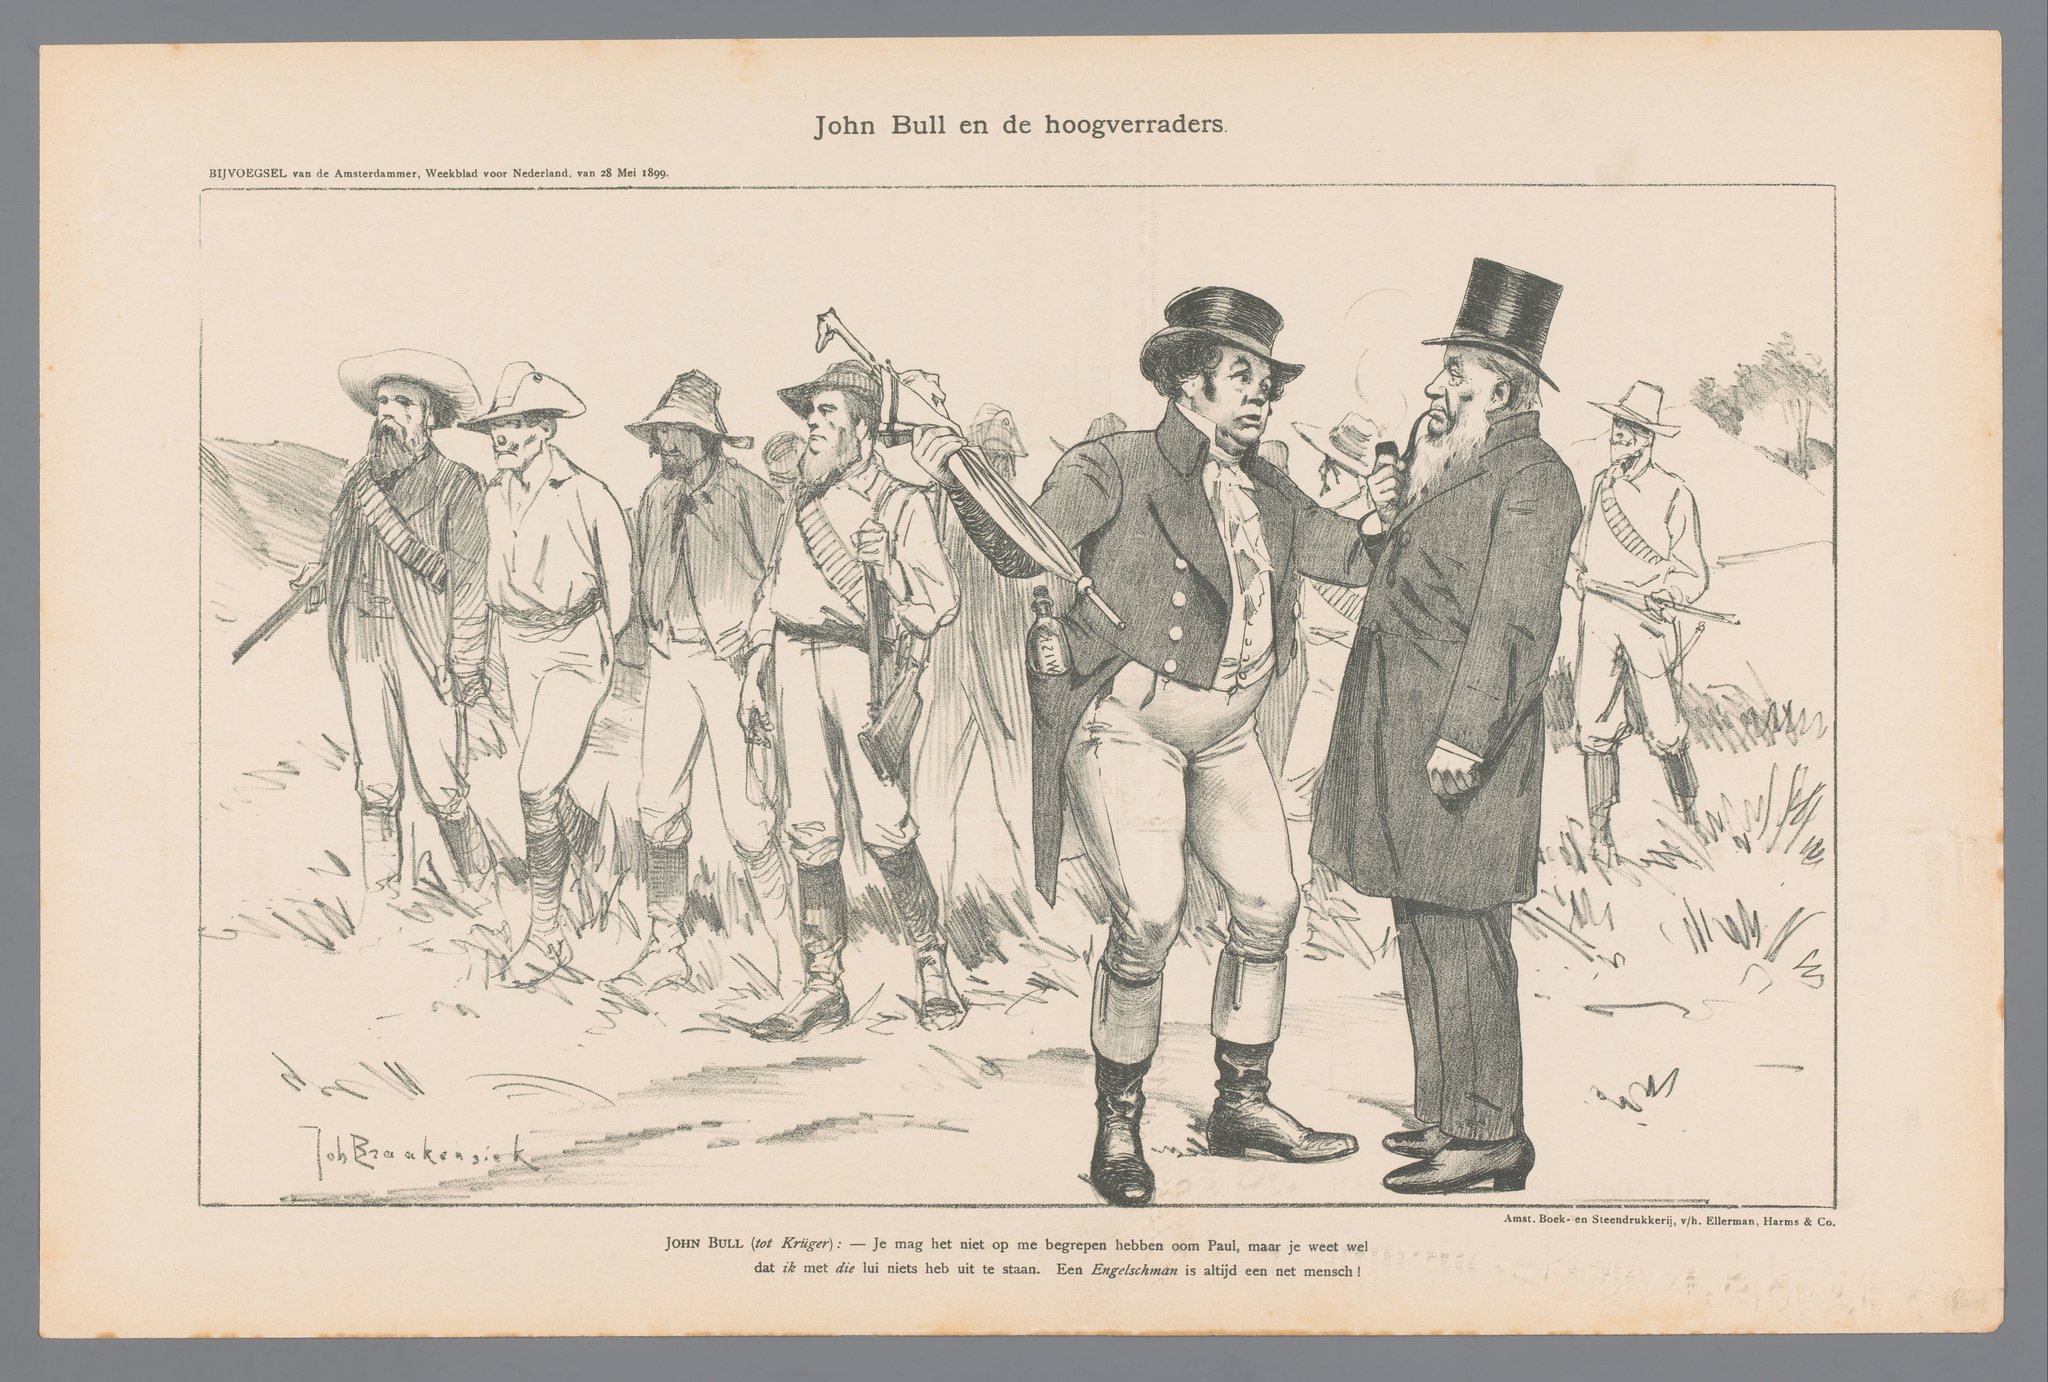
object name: cartoon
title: John Bull en de hoogverraders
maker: johan braakensiek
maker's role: draughtsman, print maker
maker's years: 1858-1940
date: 1899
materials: paper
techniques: lithograph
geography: amsterdam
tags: historical persons, political caricatures and satires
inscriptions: date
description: Prent uit het bijvoegsel van: De Amsterdammer. Weekblad voor Nederland, 28 mei 1899.